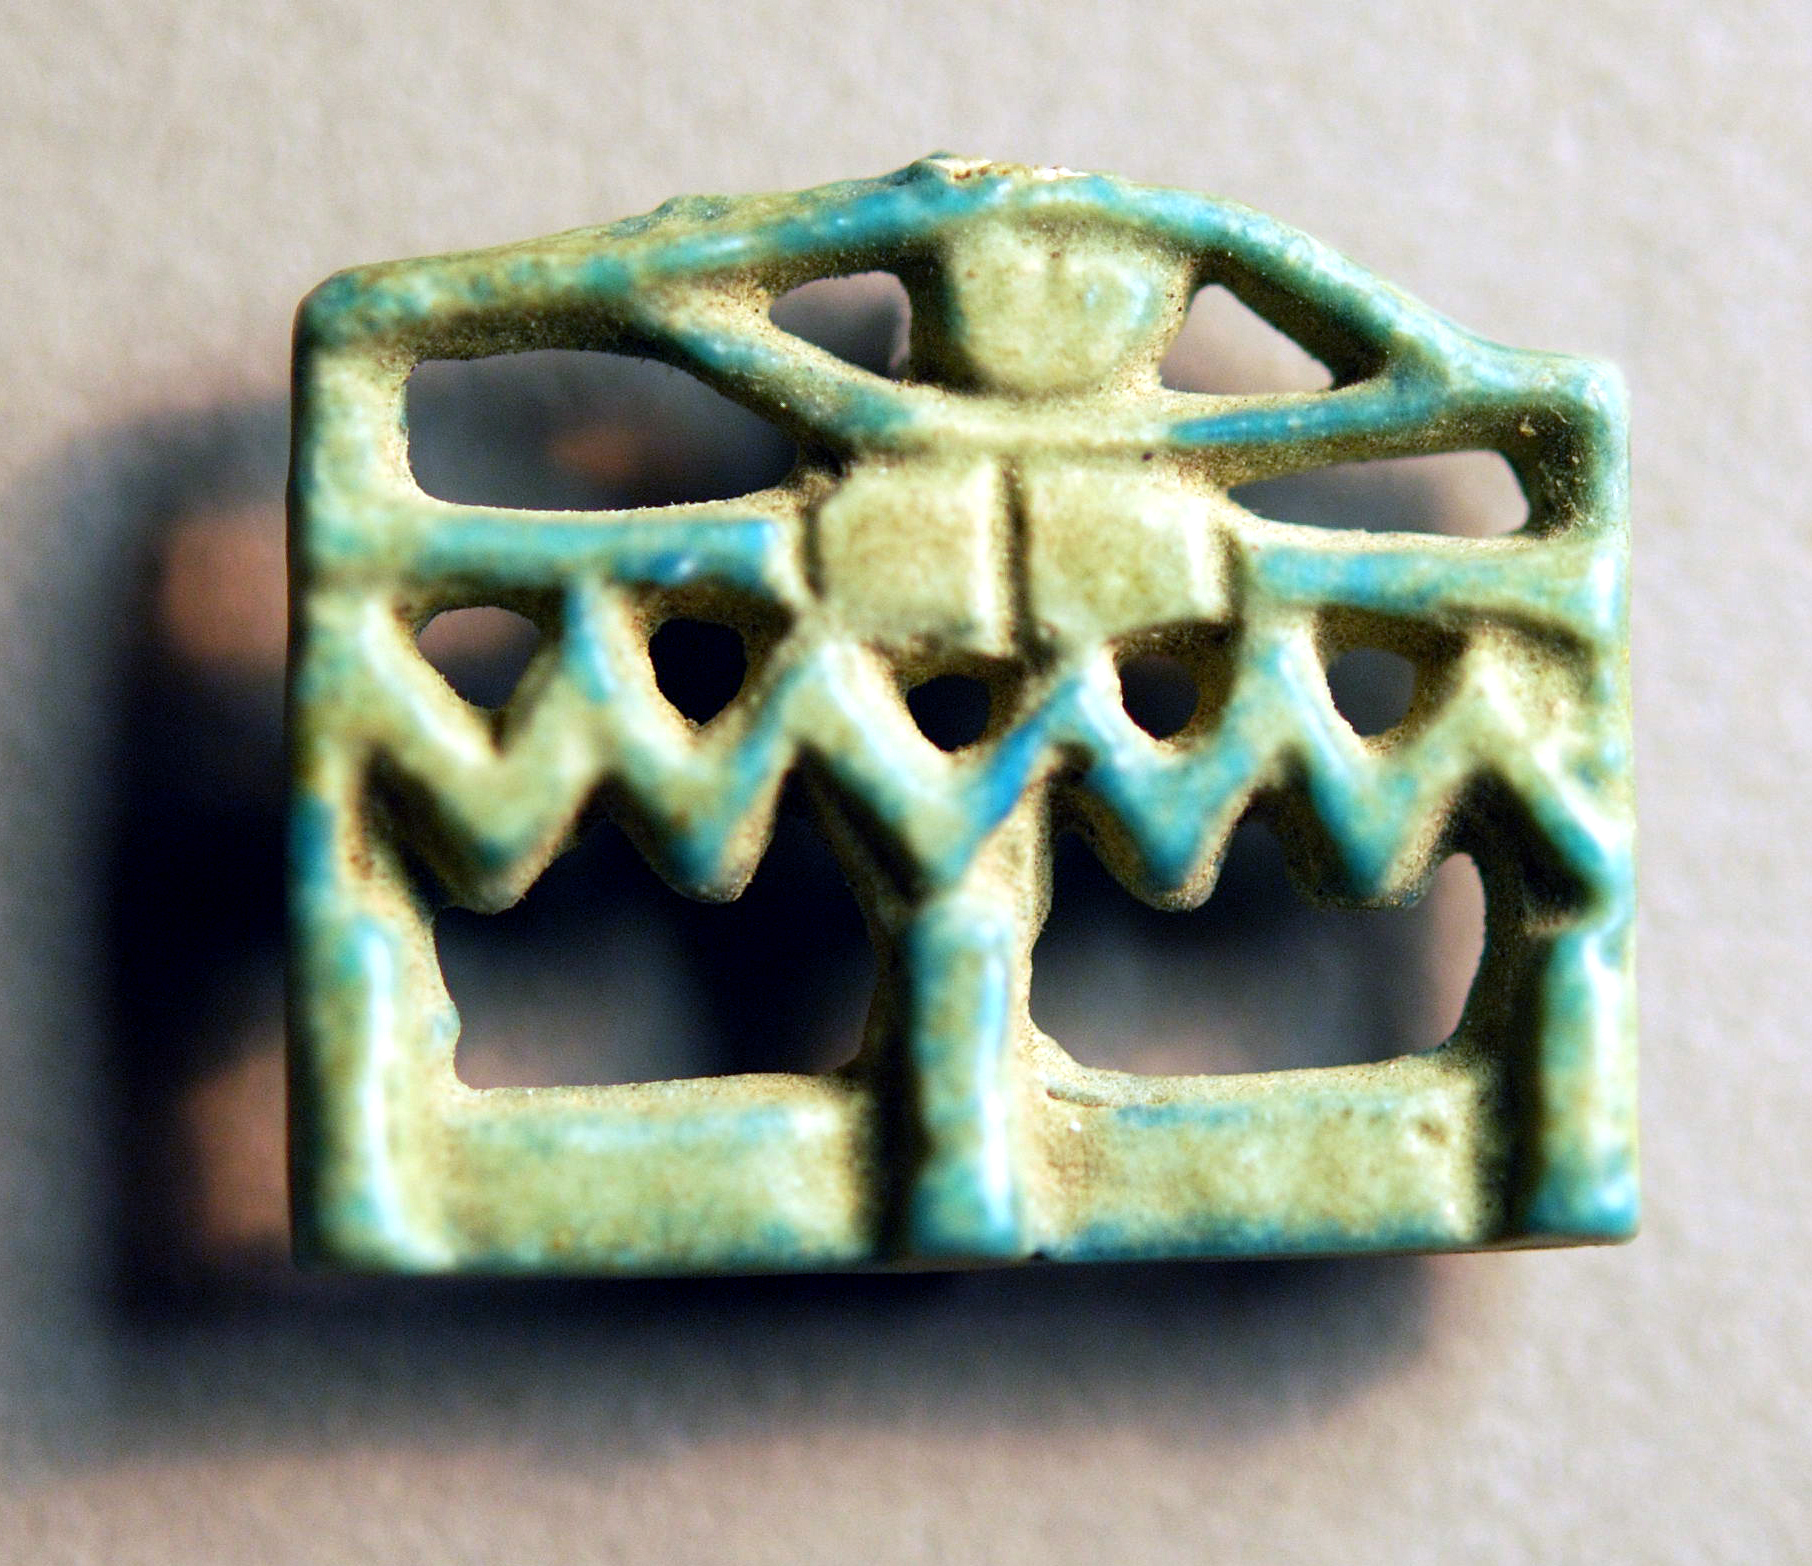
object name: amulet, hieroglyphic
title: Hieroglyphic Amulet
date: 1390-1352 BCE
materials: faience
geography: egypt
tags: hieroglyphs